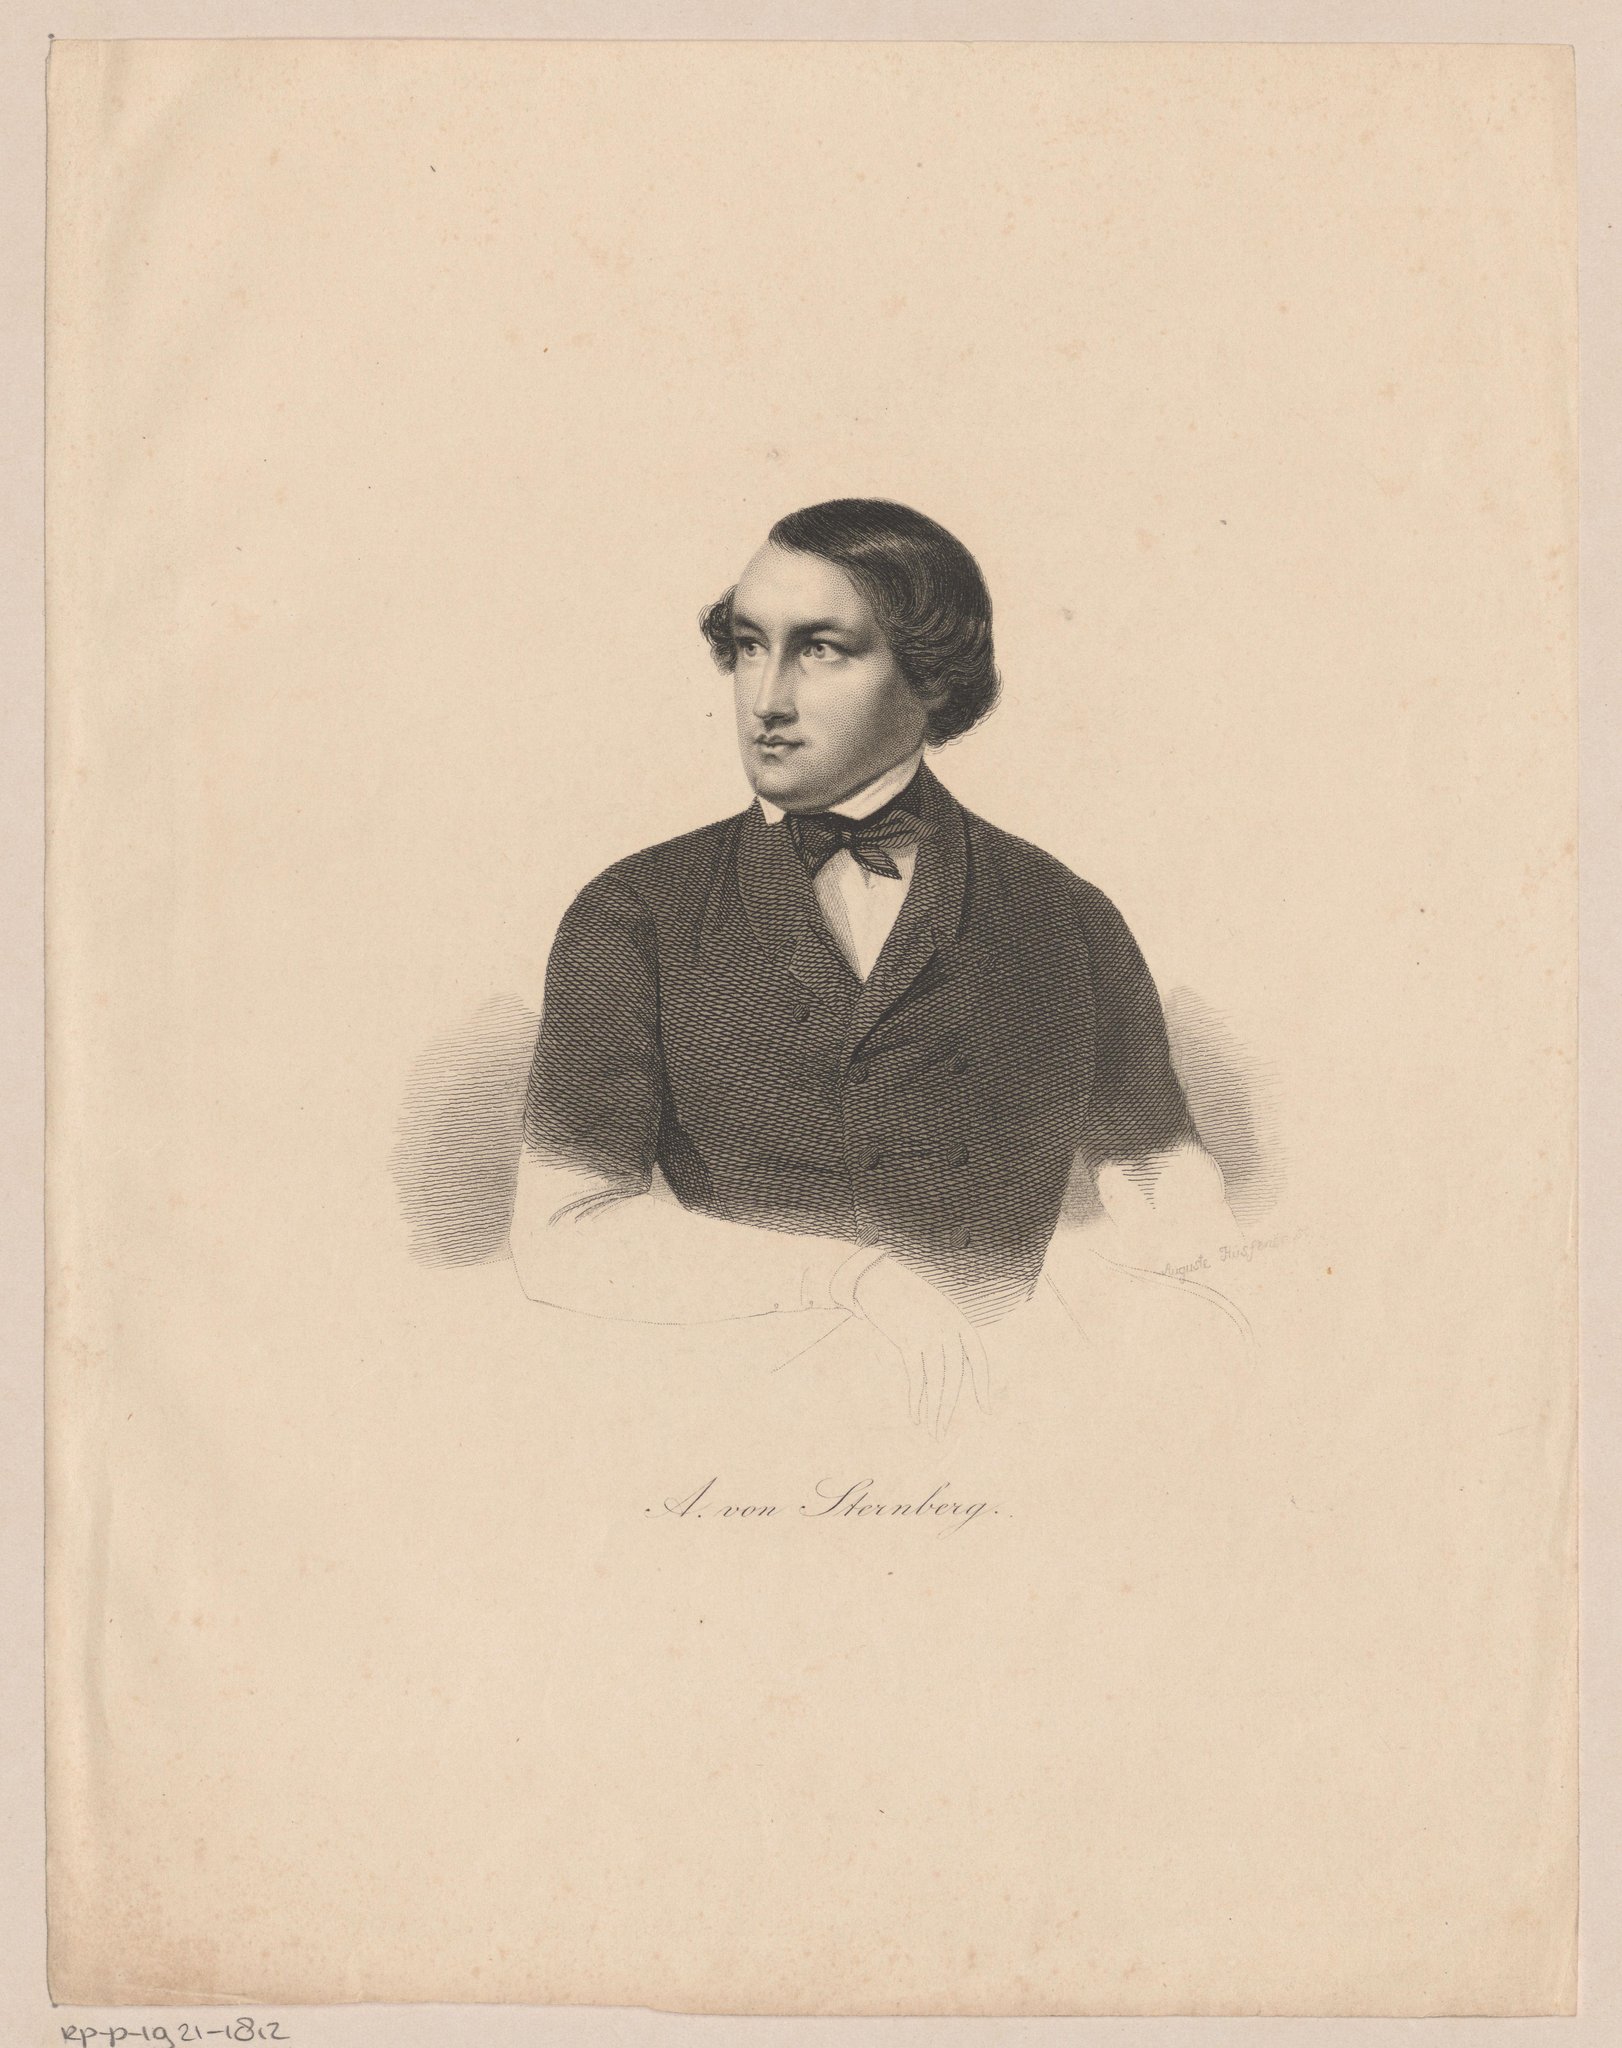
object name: print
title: Portret van Alexander von Ungern-Sternberg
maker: auguste hüssener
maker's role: print maker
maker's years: 1789-1877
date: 1826-1877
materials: paper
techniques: intaglio, engraving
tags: historical persons, portrait of a writer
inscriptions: collector's mark: Lugt 2233